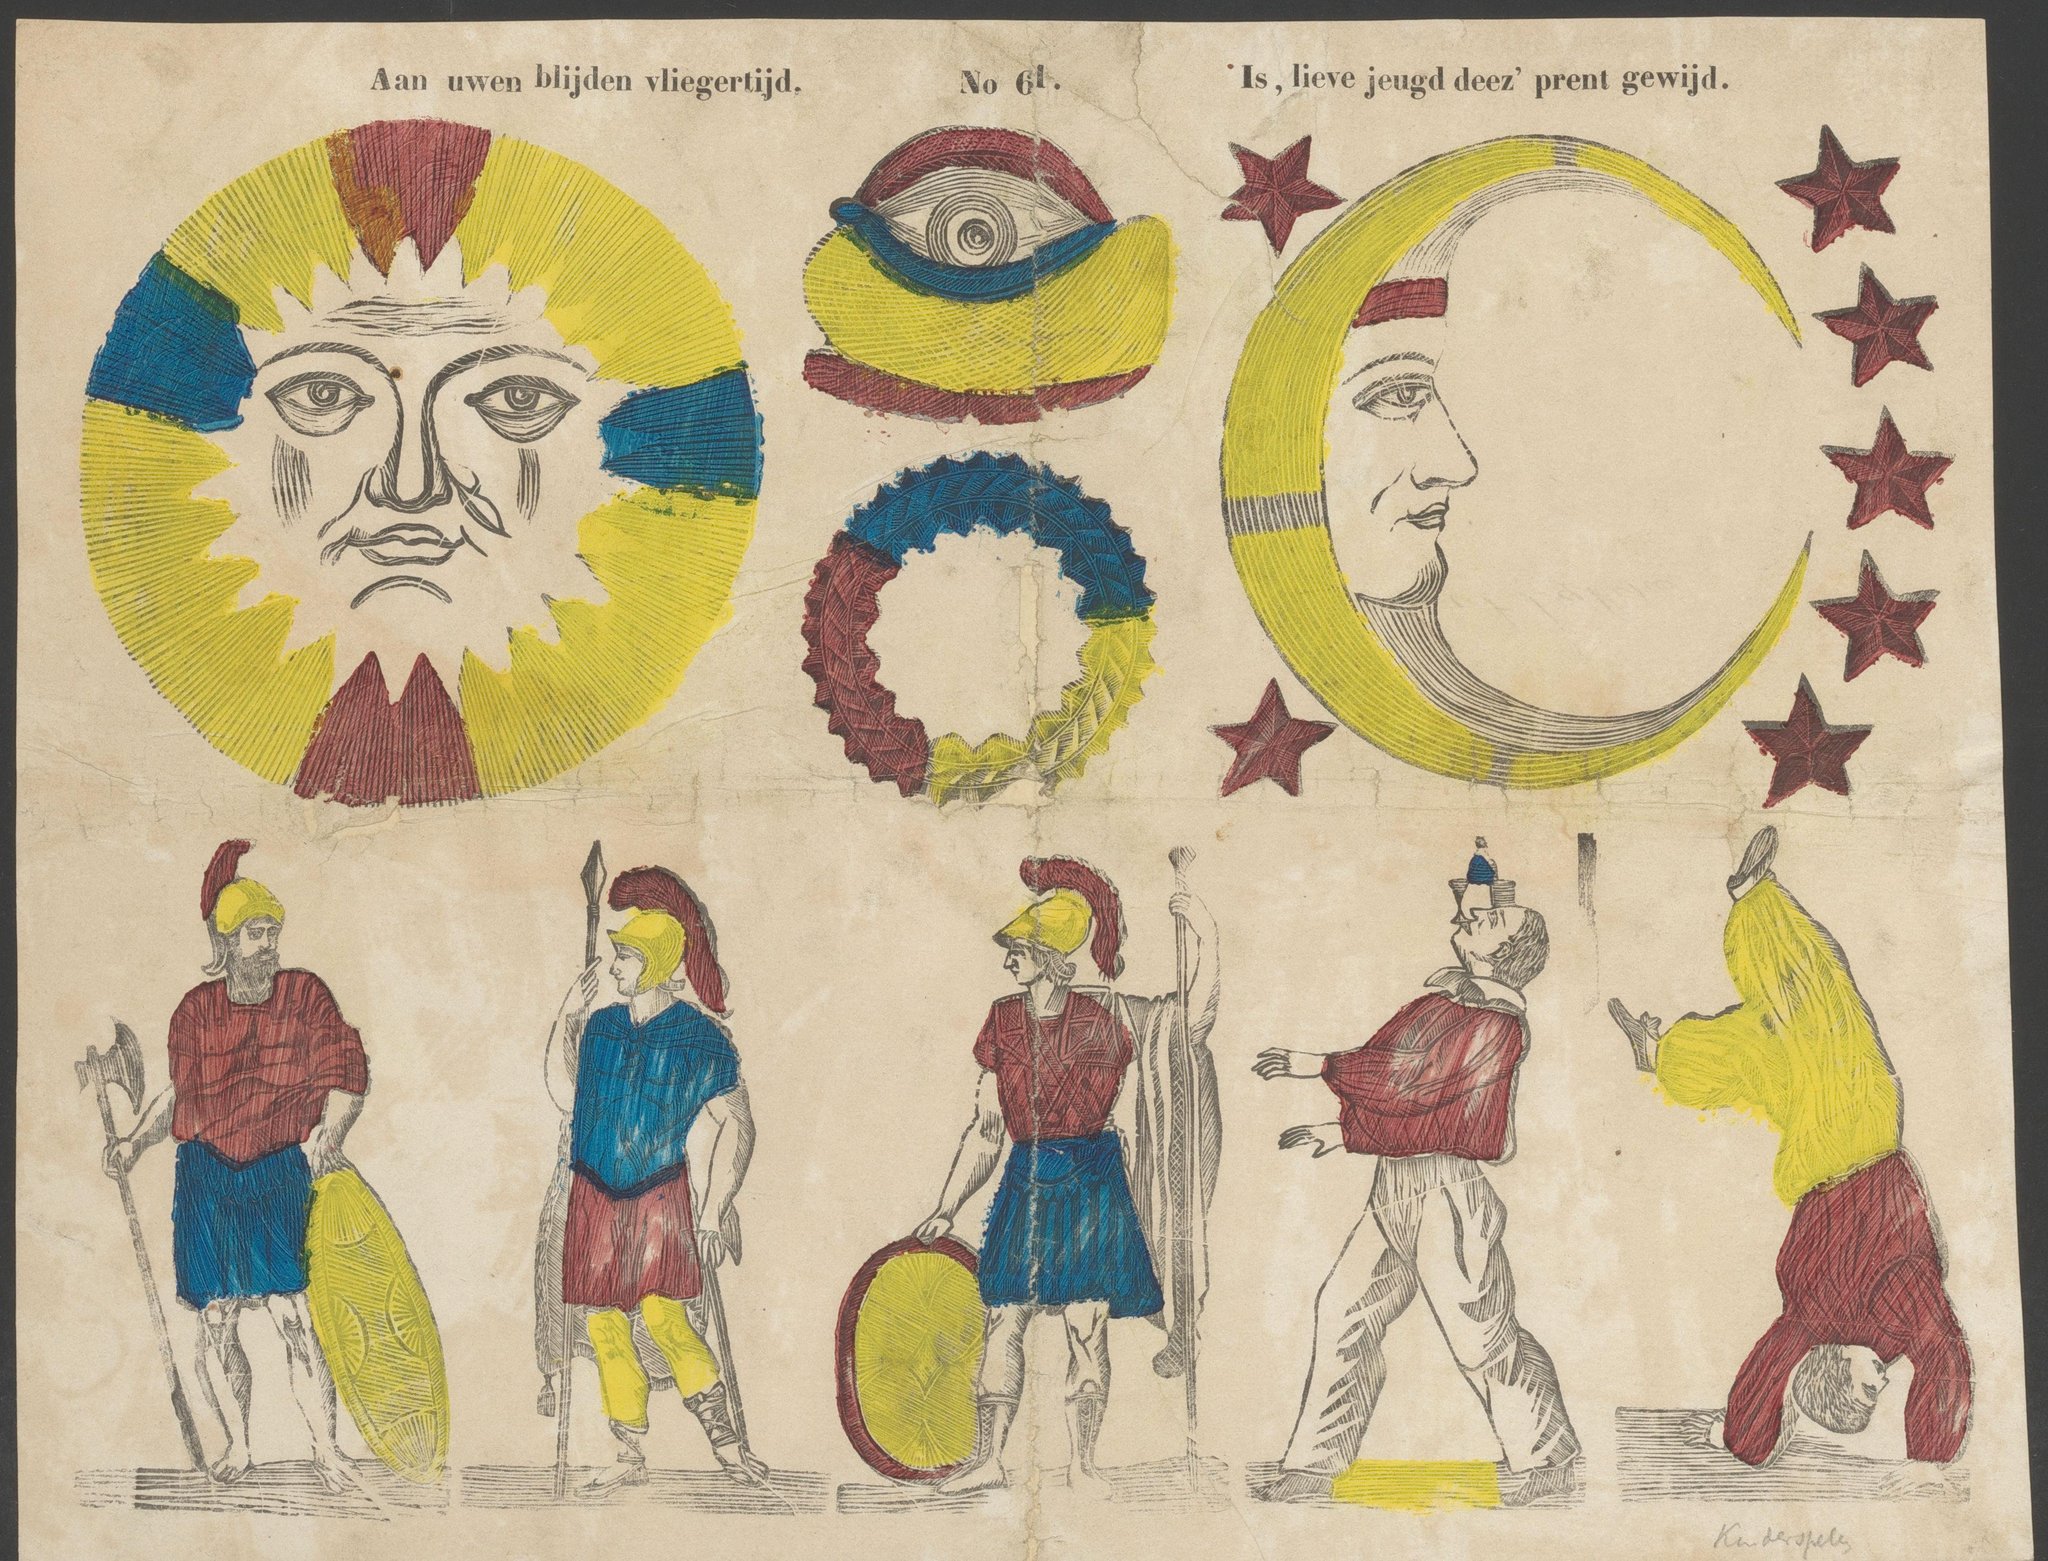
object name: print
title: Versieringen voor vliegers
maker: Anonymous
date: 1848-1881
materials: paper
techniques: hand coloring, letterpress printing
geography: den bosch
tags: sun as celestial body, the soldier; the soldier's life, moon as celestial body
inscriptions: collector's mark: Lugt 1641, stamp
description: Blad met acht voorstellingen van figuren om uit te knippen en op een vlieger te plakken, waaronder de zon, de maan en Romeinse soldaten. Genummerd midden boven: No. 61. Onderwerpsrubrieken binnen de Atlas Zeden en Gewoonten: Zeden en Gewoonten in Engeren Zin, Des menschen beging, midden en einde, Kinderleven – Kinderspel en Kinderprenten.